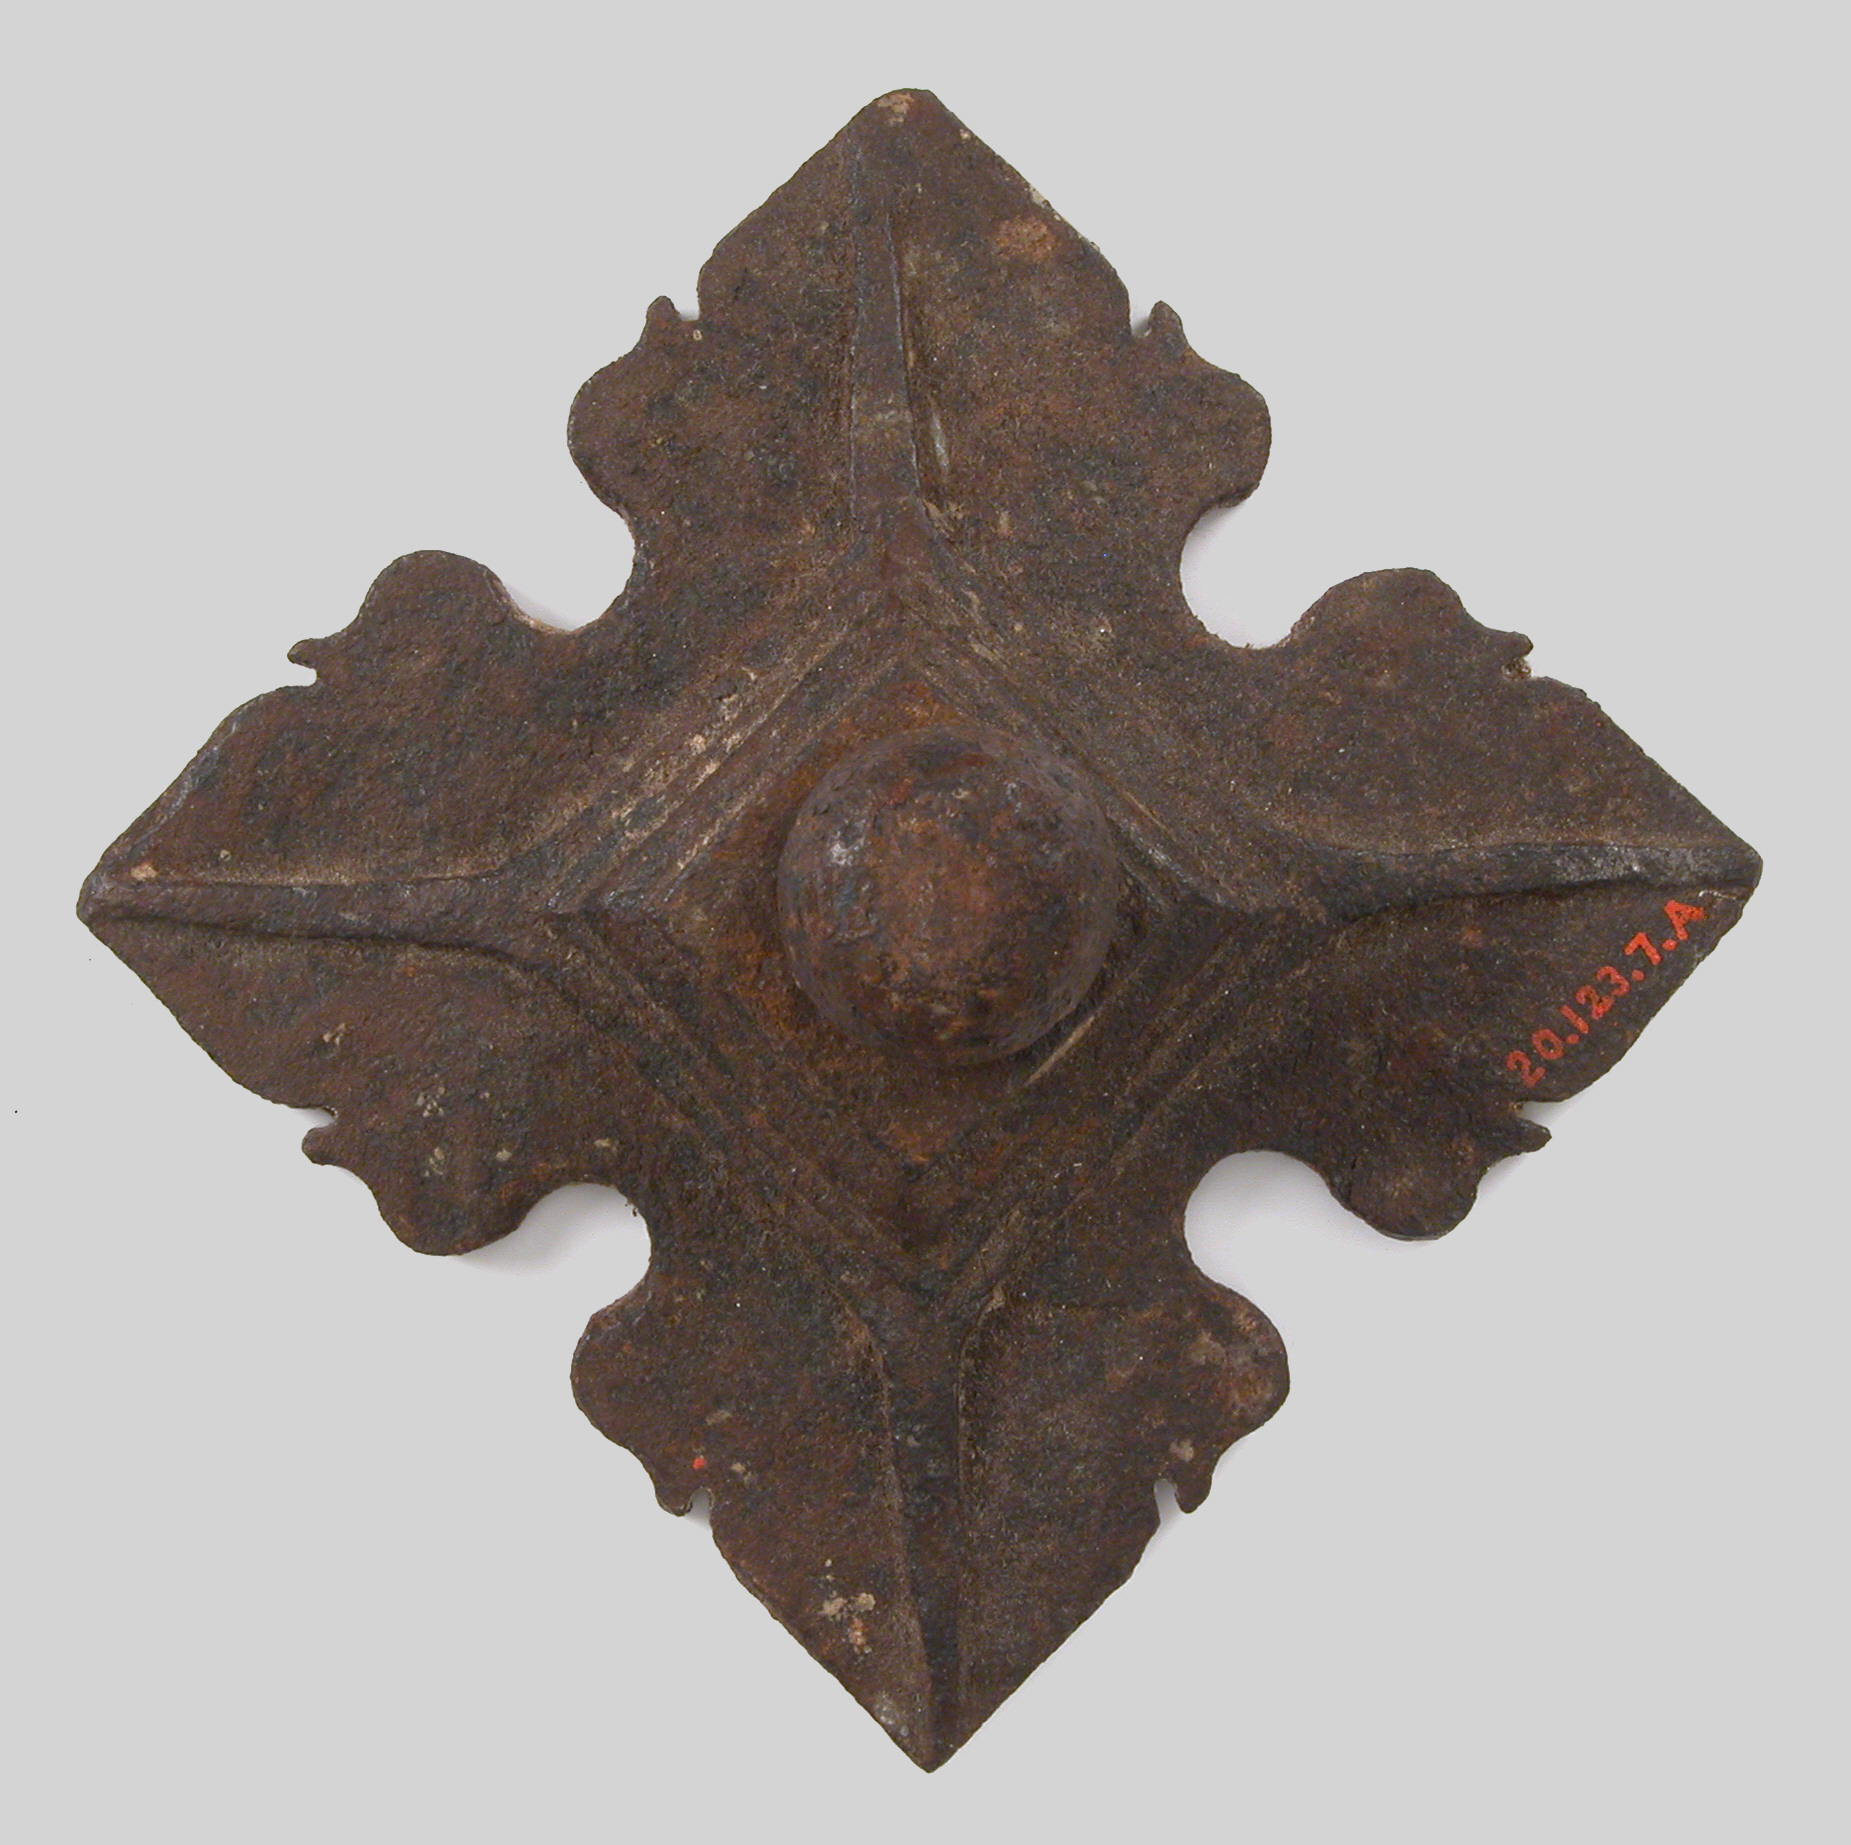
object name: nail head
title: Nail, Head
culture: french or spanish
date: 1501-1700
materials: iron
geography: spain